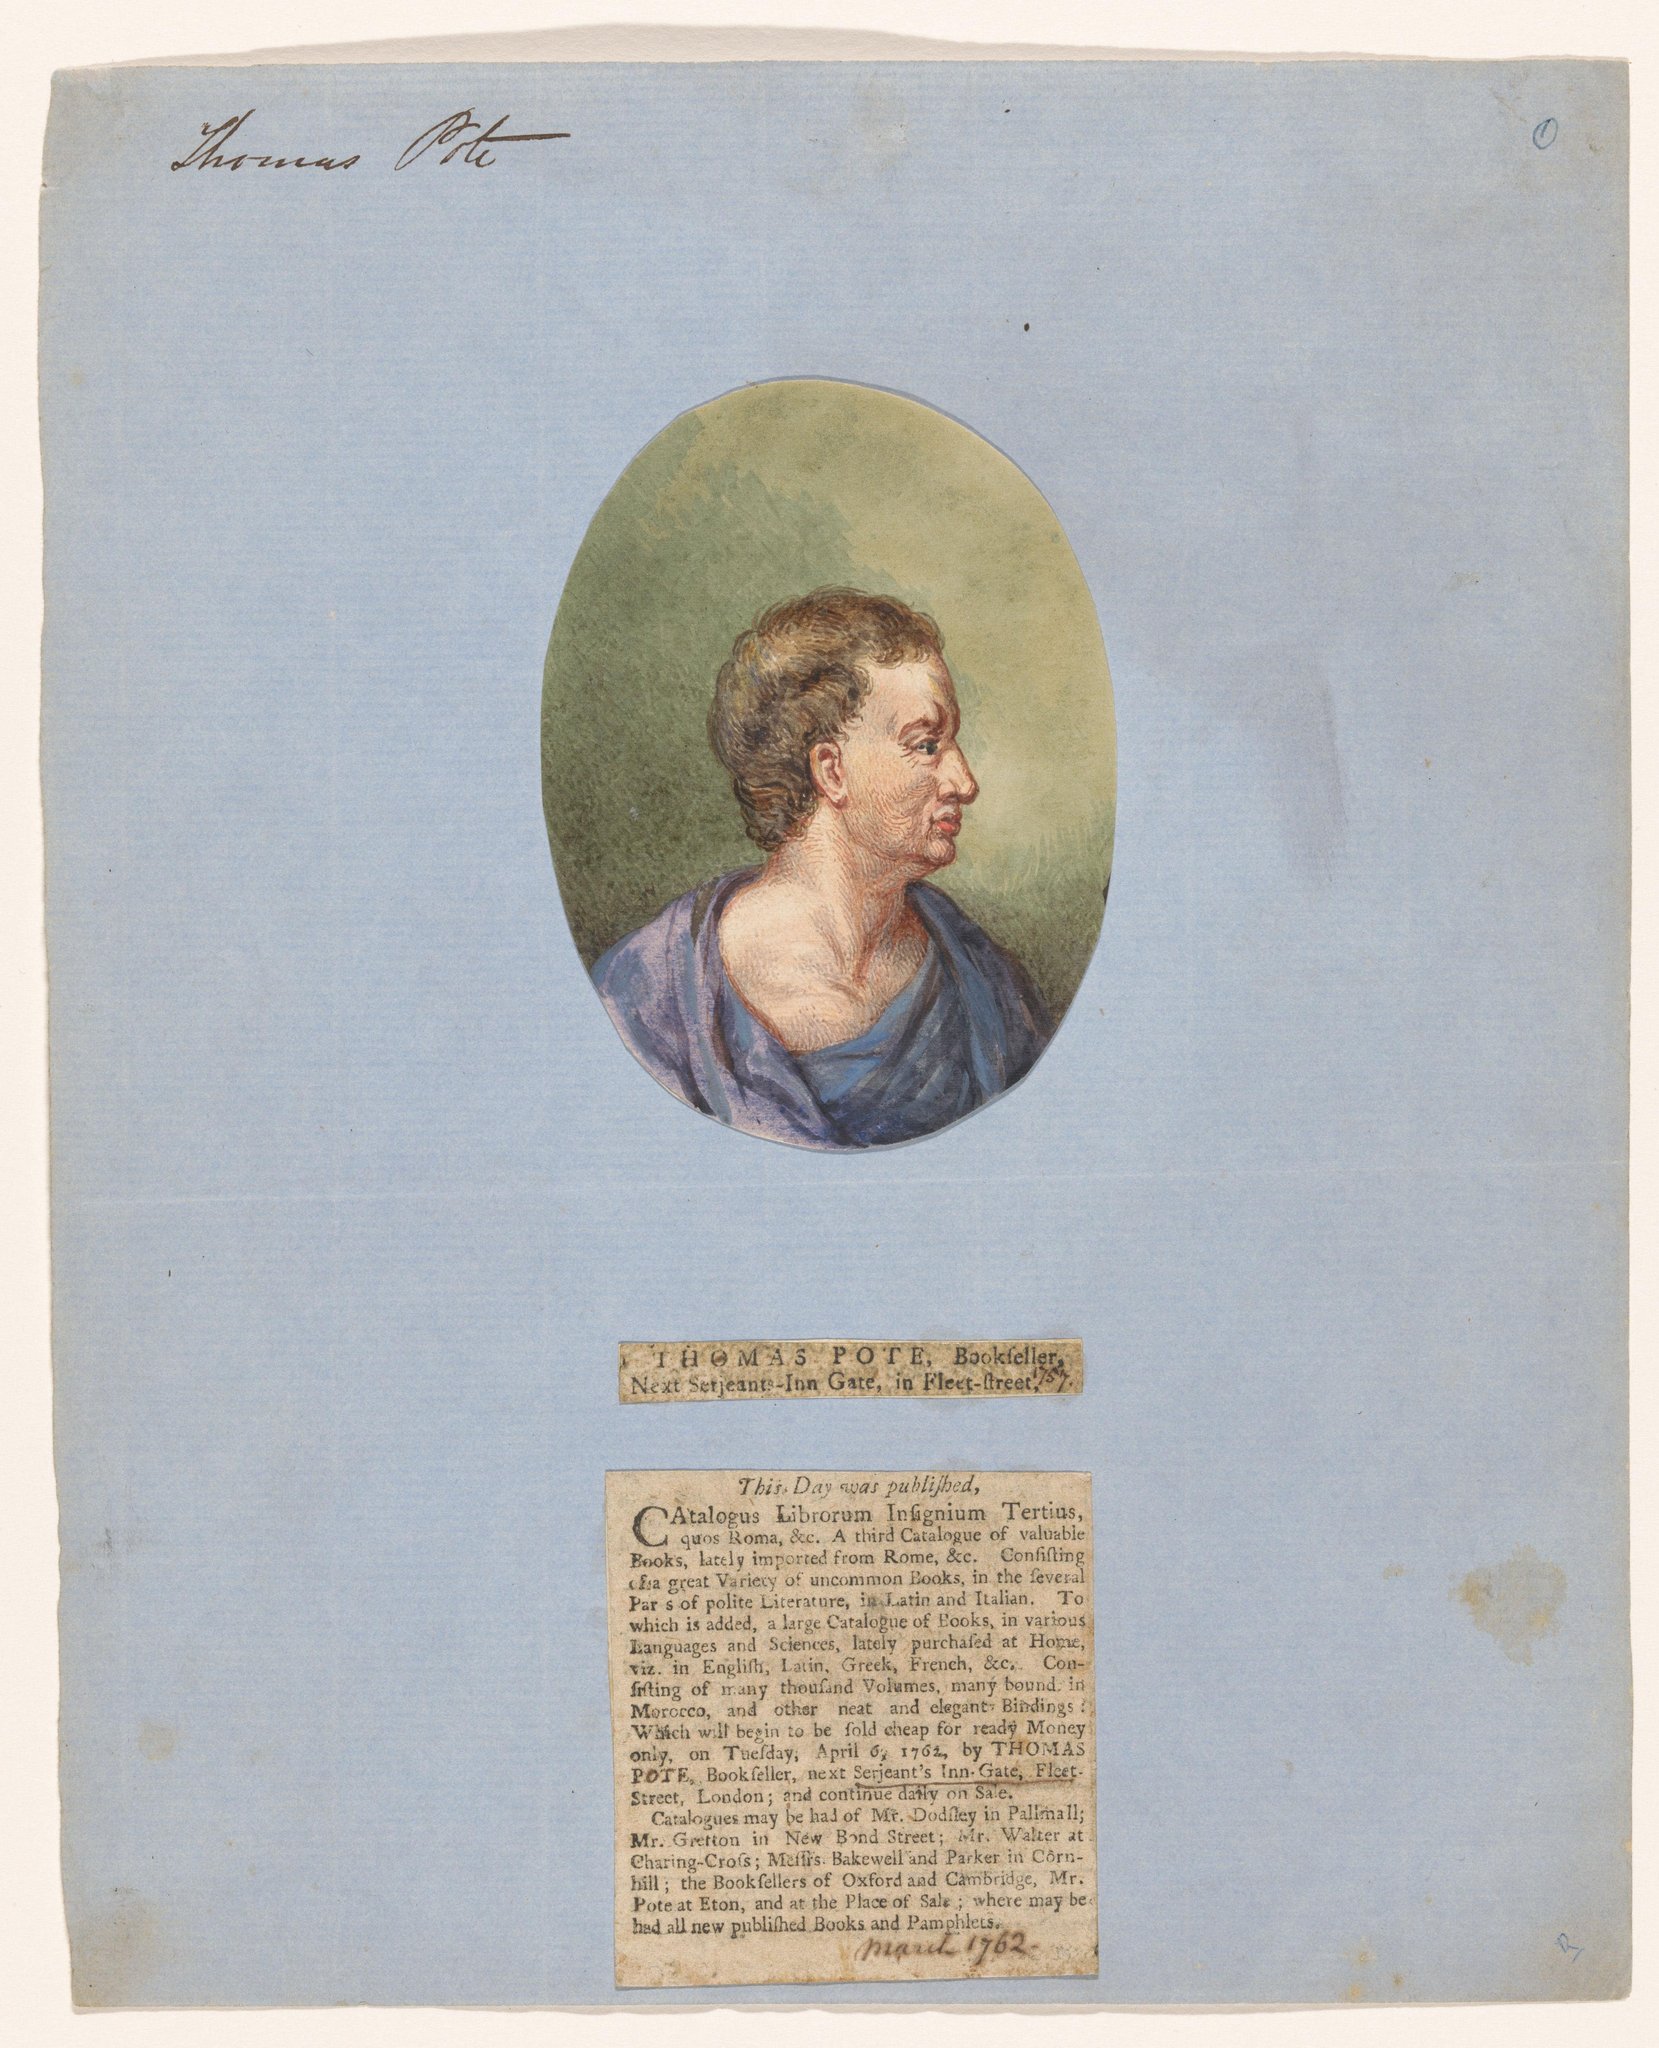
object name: drawing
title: Portret van Thomas Pote, boekhandelaar en drukker te Eton en Londen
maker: Anonymous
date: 1800-1899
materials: paper, watercolor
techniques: brush, snipping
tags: printer, bookseller, historical persons, book-shop, bookseller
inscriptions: collector's mark: Lugt 2228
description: Op een blauw opzetvel, samen met een krantenknipsel.